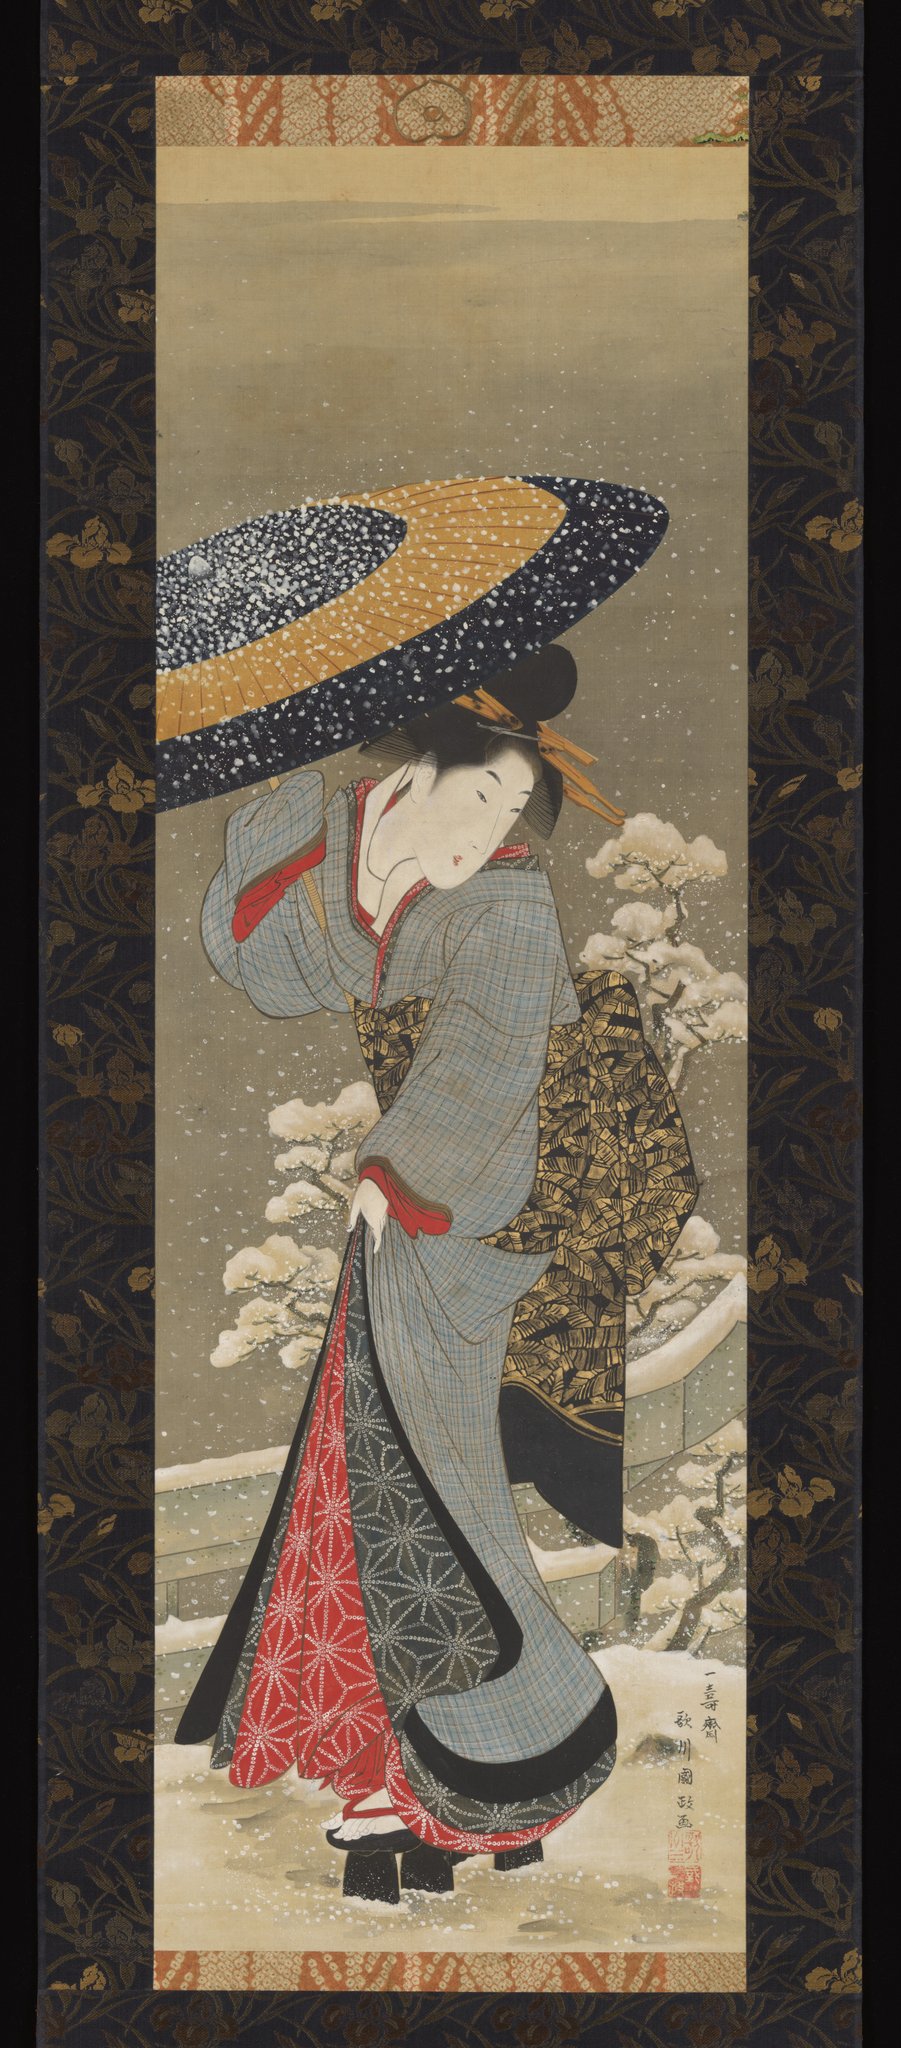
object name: hanging scroll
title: Beauty in Snow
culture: japanese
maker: utagawa kunimasa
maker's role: artist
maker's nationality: japanese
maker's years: 1773-1810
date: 1804-1818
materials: ink, silk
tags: women,snow,umbrellas